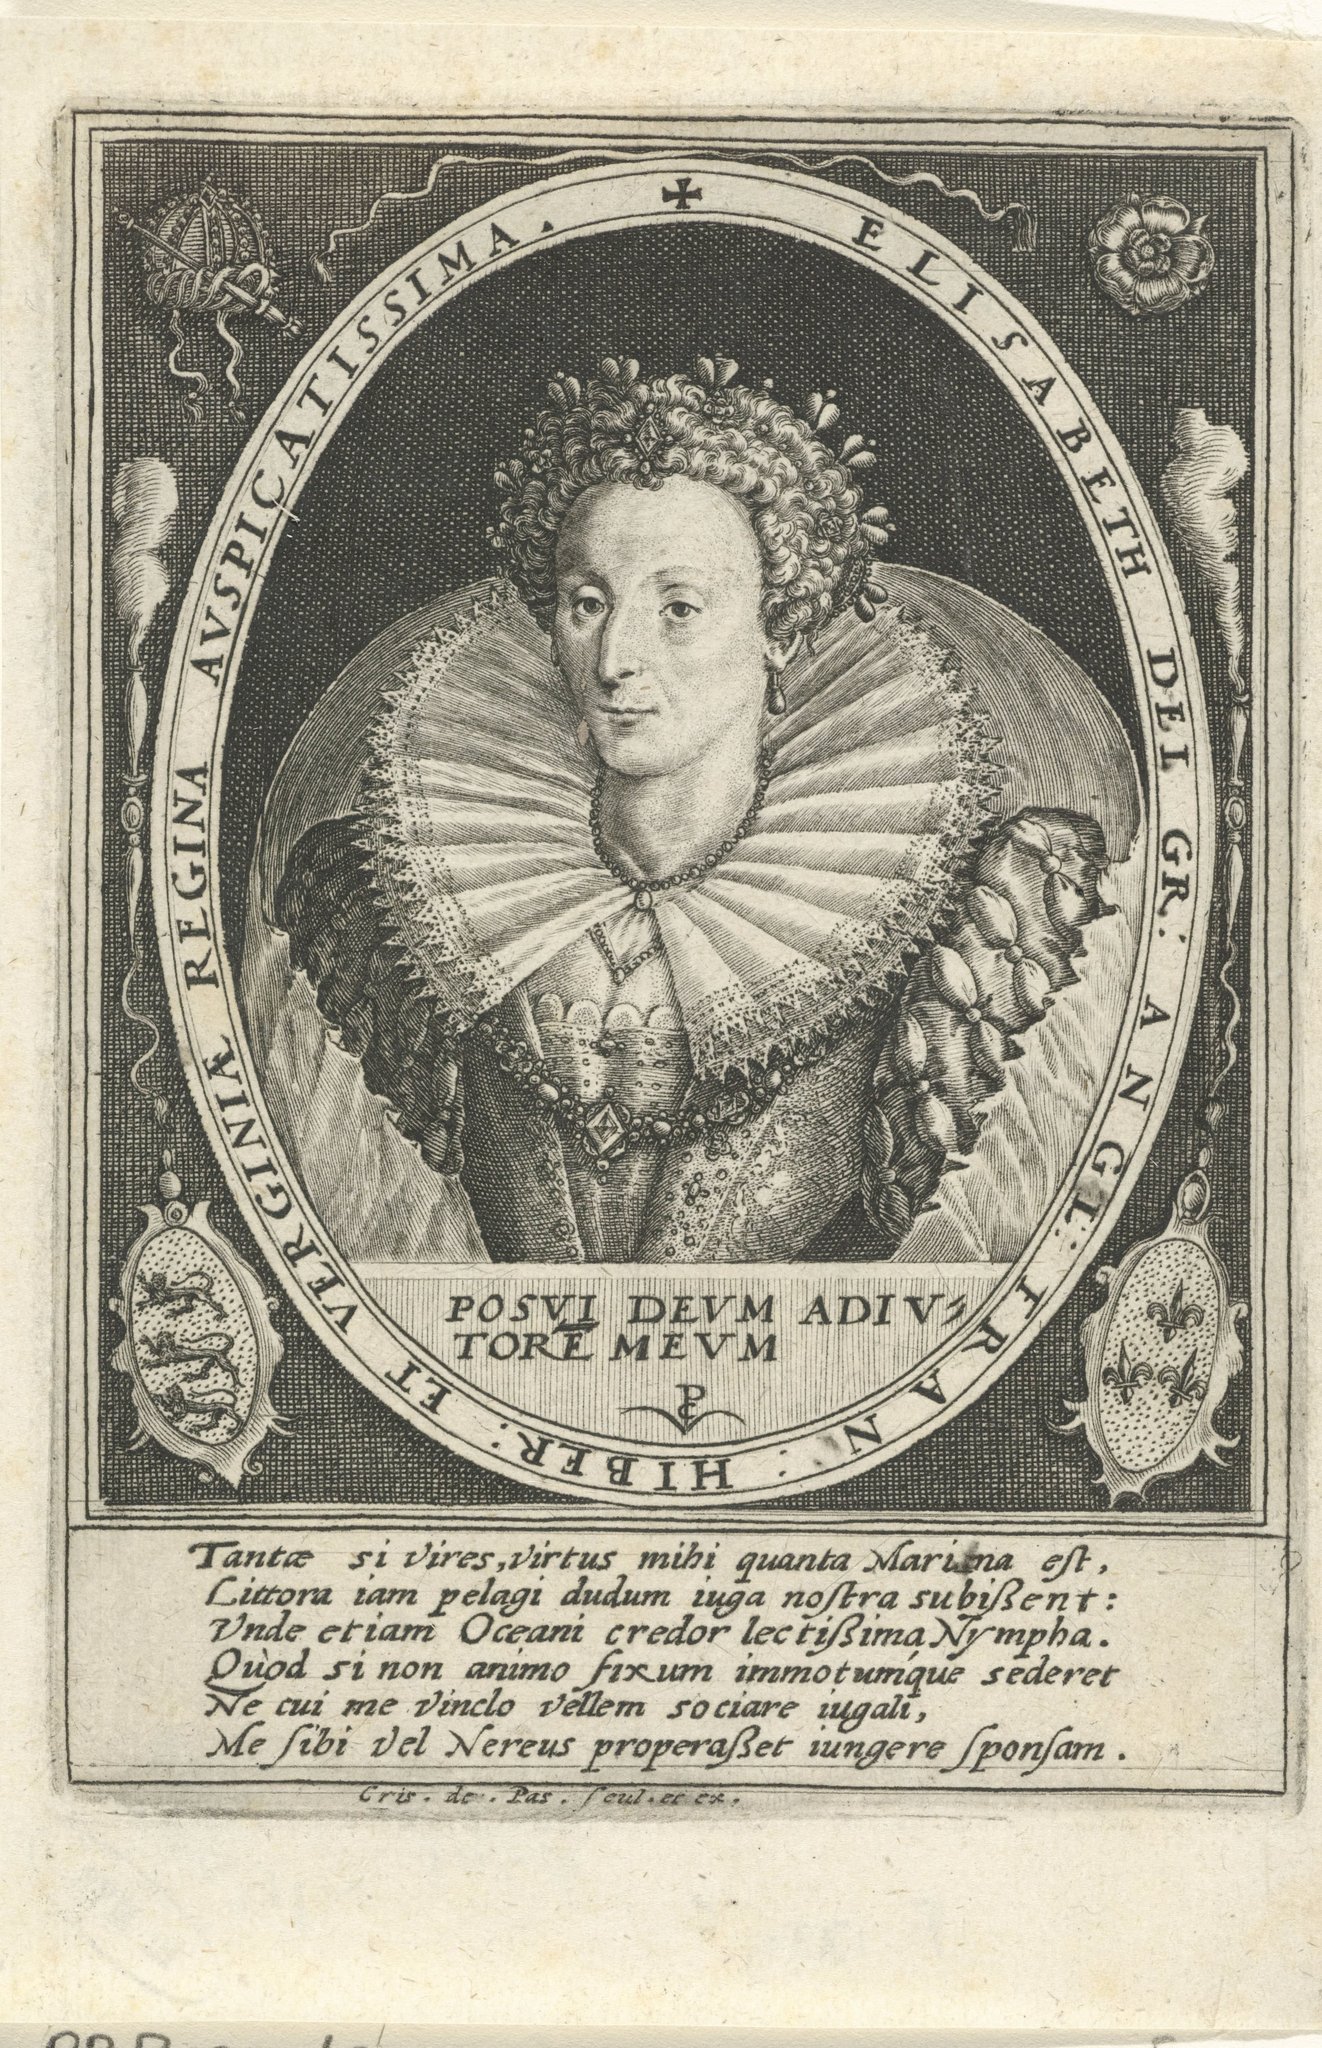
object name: print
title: Regiae Anglicae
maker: crispijn van de passe (i)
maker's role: draughtsman, print maker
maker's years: 1564-1637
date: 1604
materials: paper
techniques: engraving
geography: cologne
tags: insignia and symbols of sovereignty (crown, diadem, sceptre, orb, seal, standard, cloak, pectoral)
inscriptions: collector's mark: Lugt 2228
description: Portret van Elizabeth I Tudor, koningin van Engeland, eronder haar devies in het Latijn. In het randschrift van de omlijsting de naam en functie van de geportretteerde in het Latijn. In de marge een zesregelig lofdicht in het Latijn.